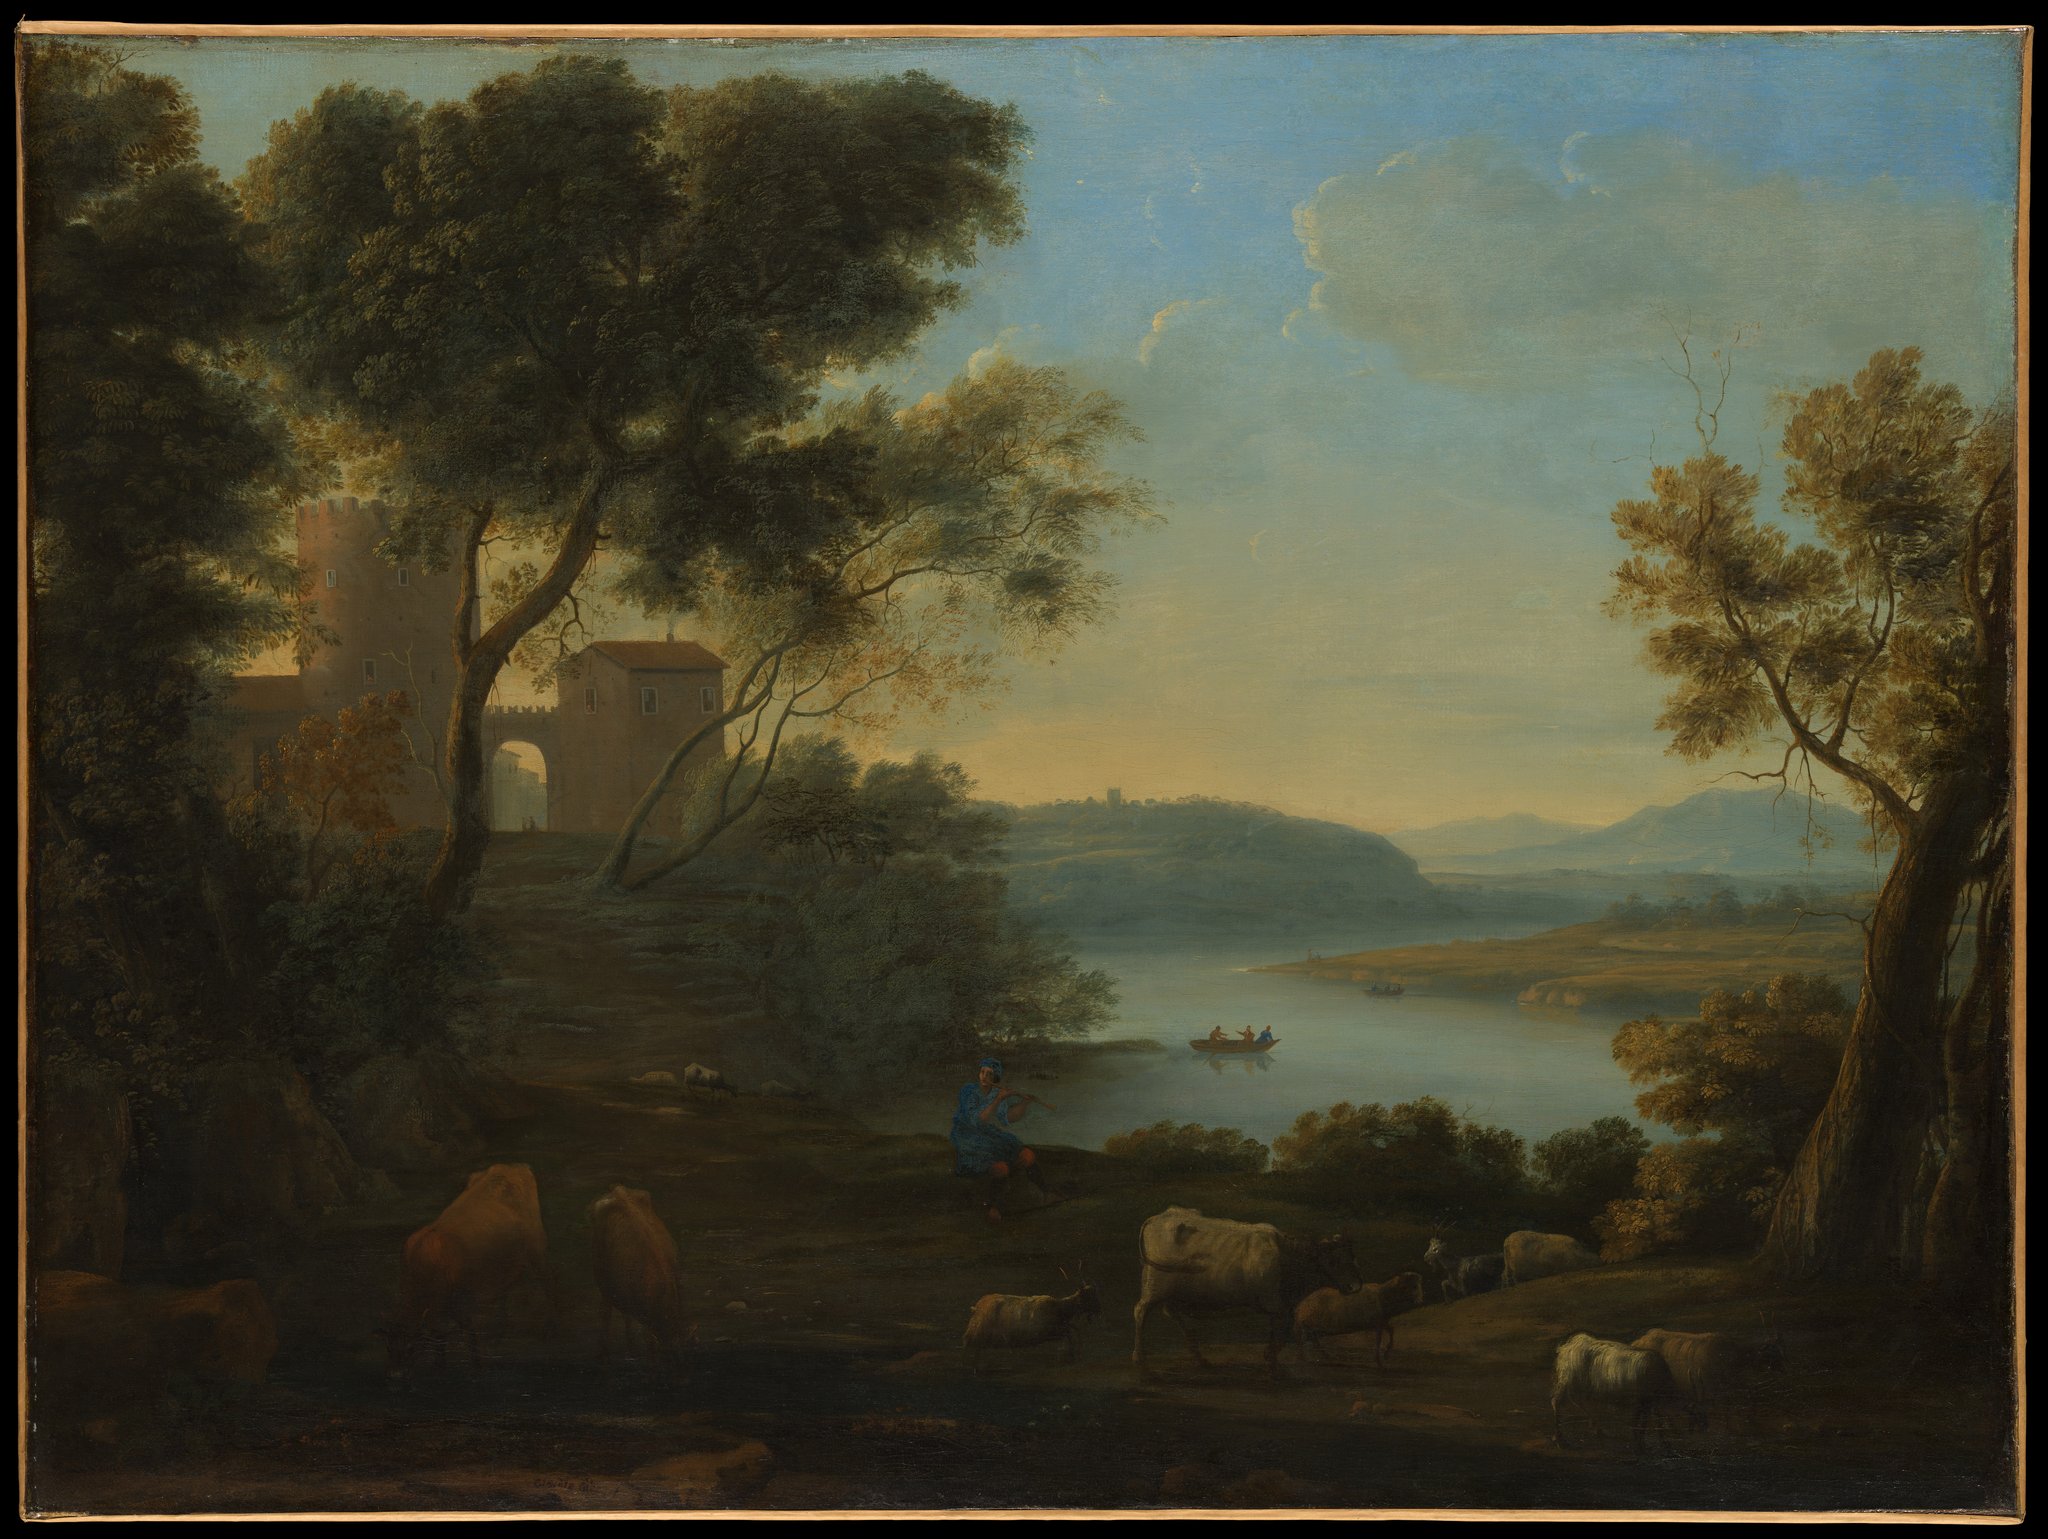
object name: painting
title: Pastoral Landscape: The Roman Campagna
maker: claude lorrain (claude gellée)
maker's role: artist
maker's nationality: french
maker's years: 1604-1682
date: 1639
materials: canvas, oil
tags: cows,rivers,landscapes,rome